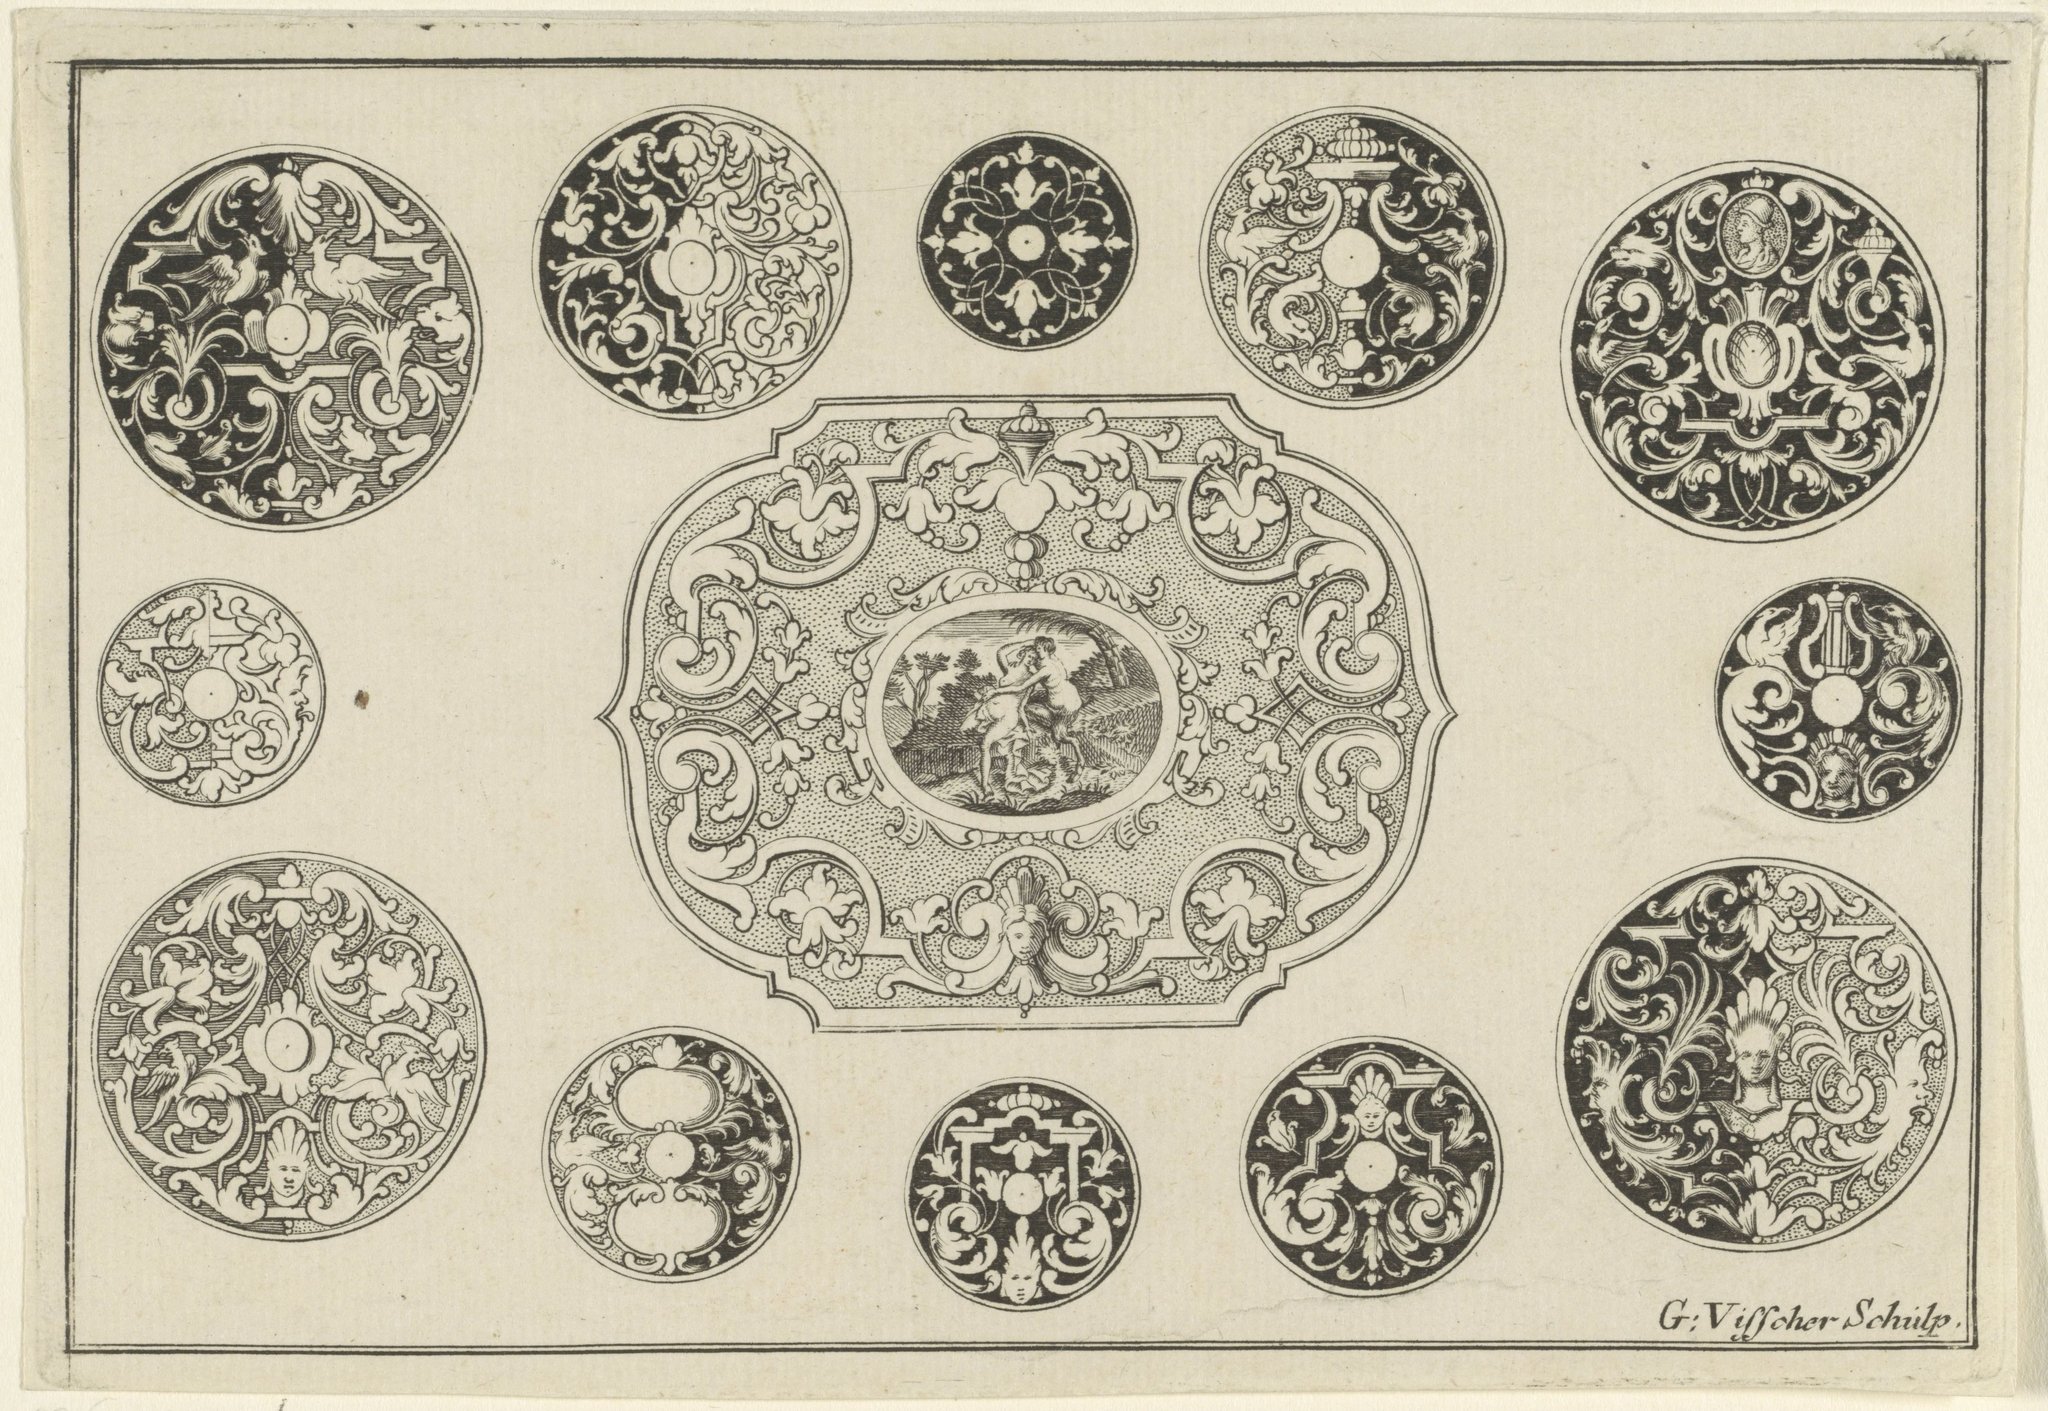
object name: print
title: Ornament met sater en naakte vrouw en verschillende ronde ornamenten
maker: gerrit visscher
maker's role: print maker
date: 1690-1710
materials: paper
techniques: engraving, etching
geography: amsterdam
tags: ornaments ~ art, love-affairs of satyr(s)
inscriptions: collector's mark: Lugt 2228